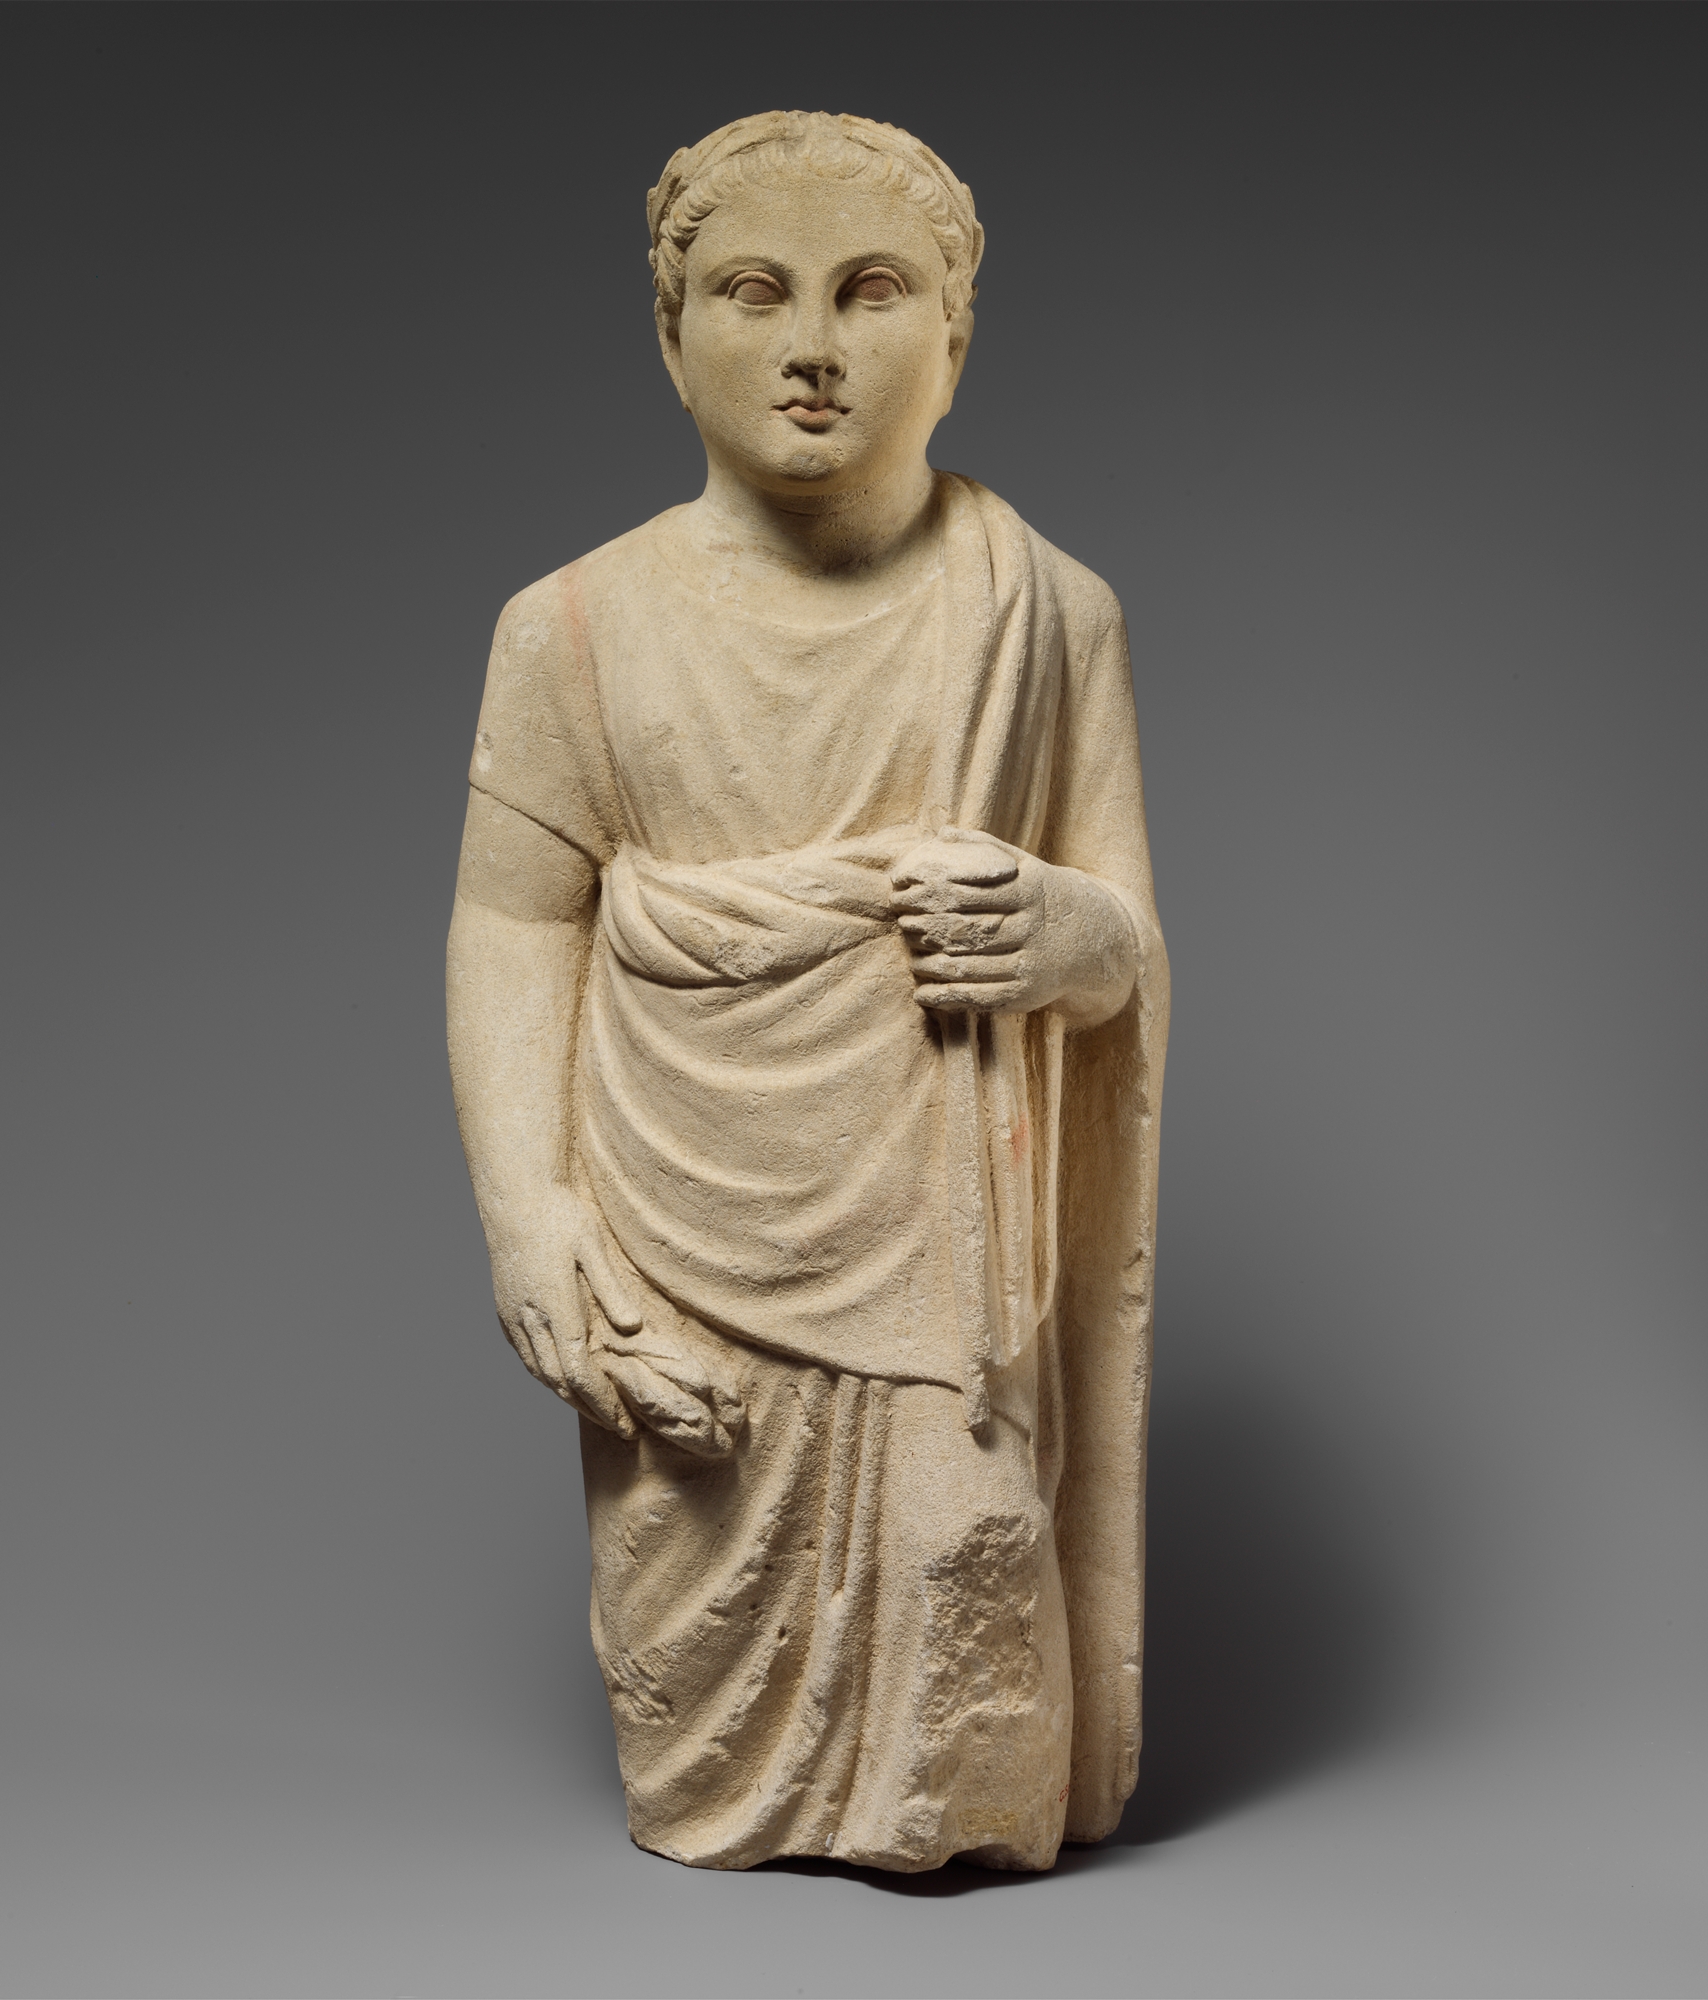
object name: statue of a votary, young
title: Limestone statuette of a boy holding a pyxis and a branch of leaves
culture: cypriot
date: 334-201 BCE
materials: limestone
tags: boys